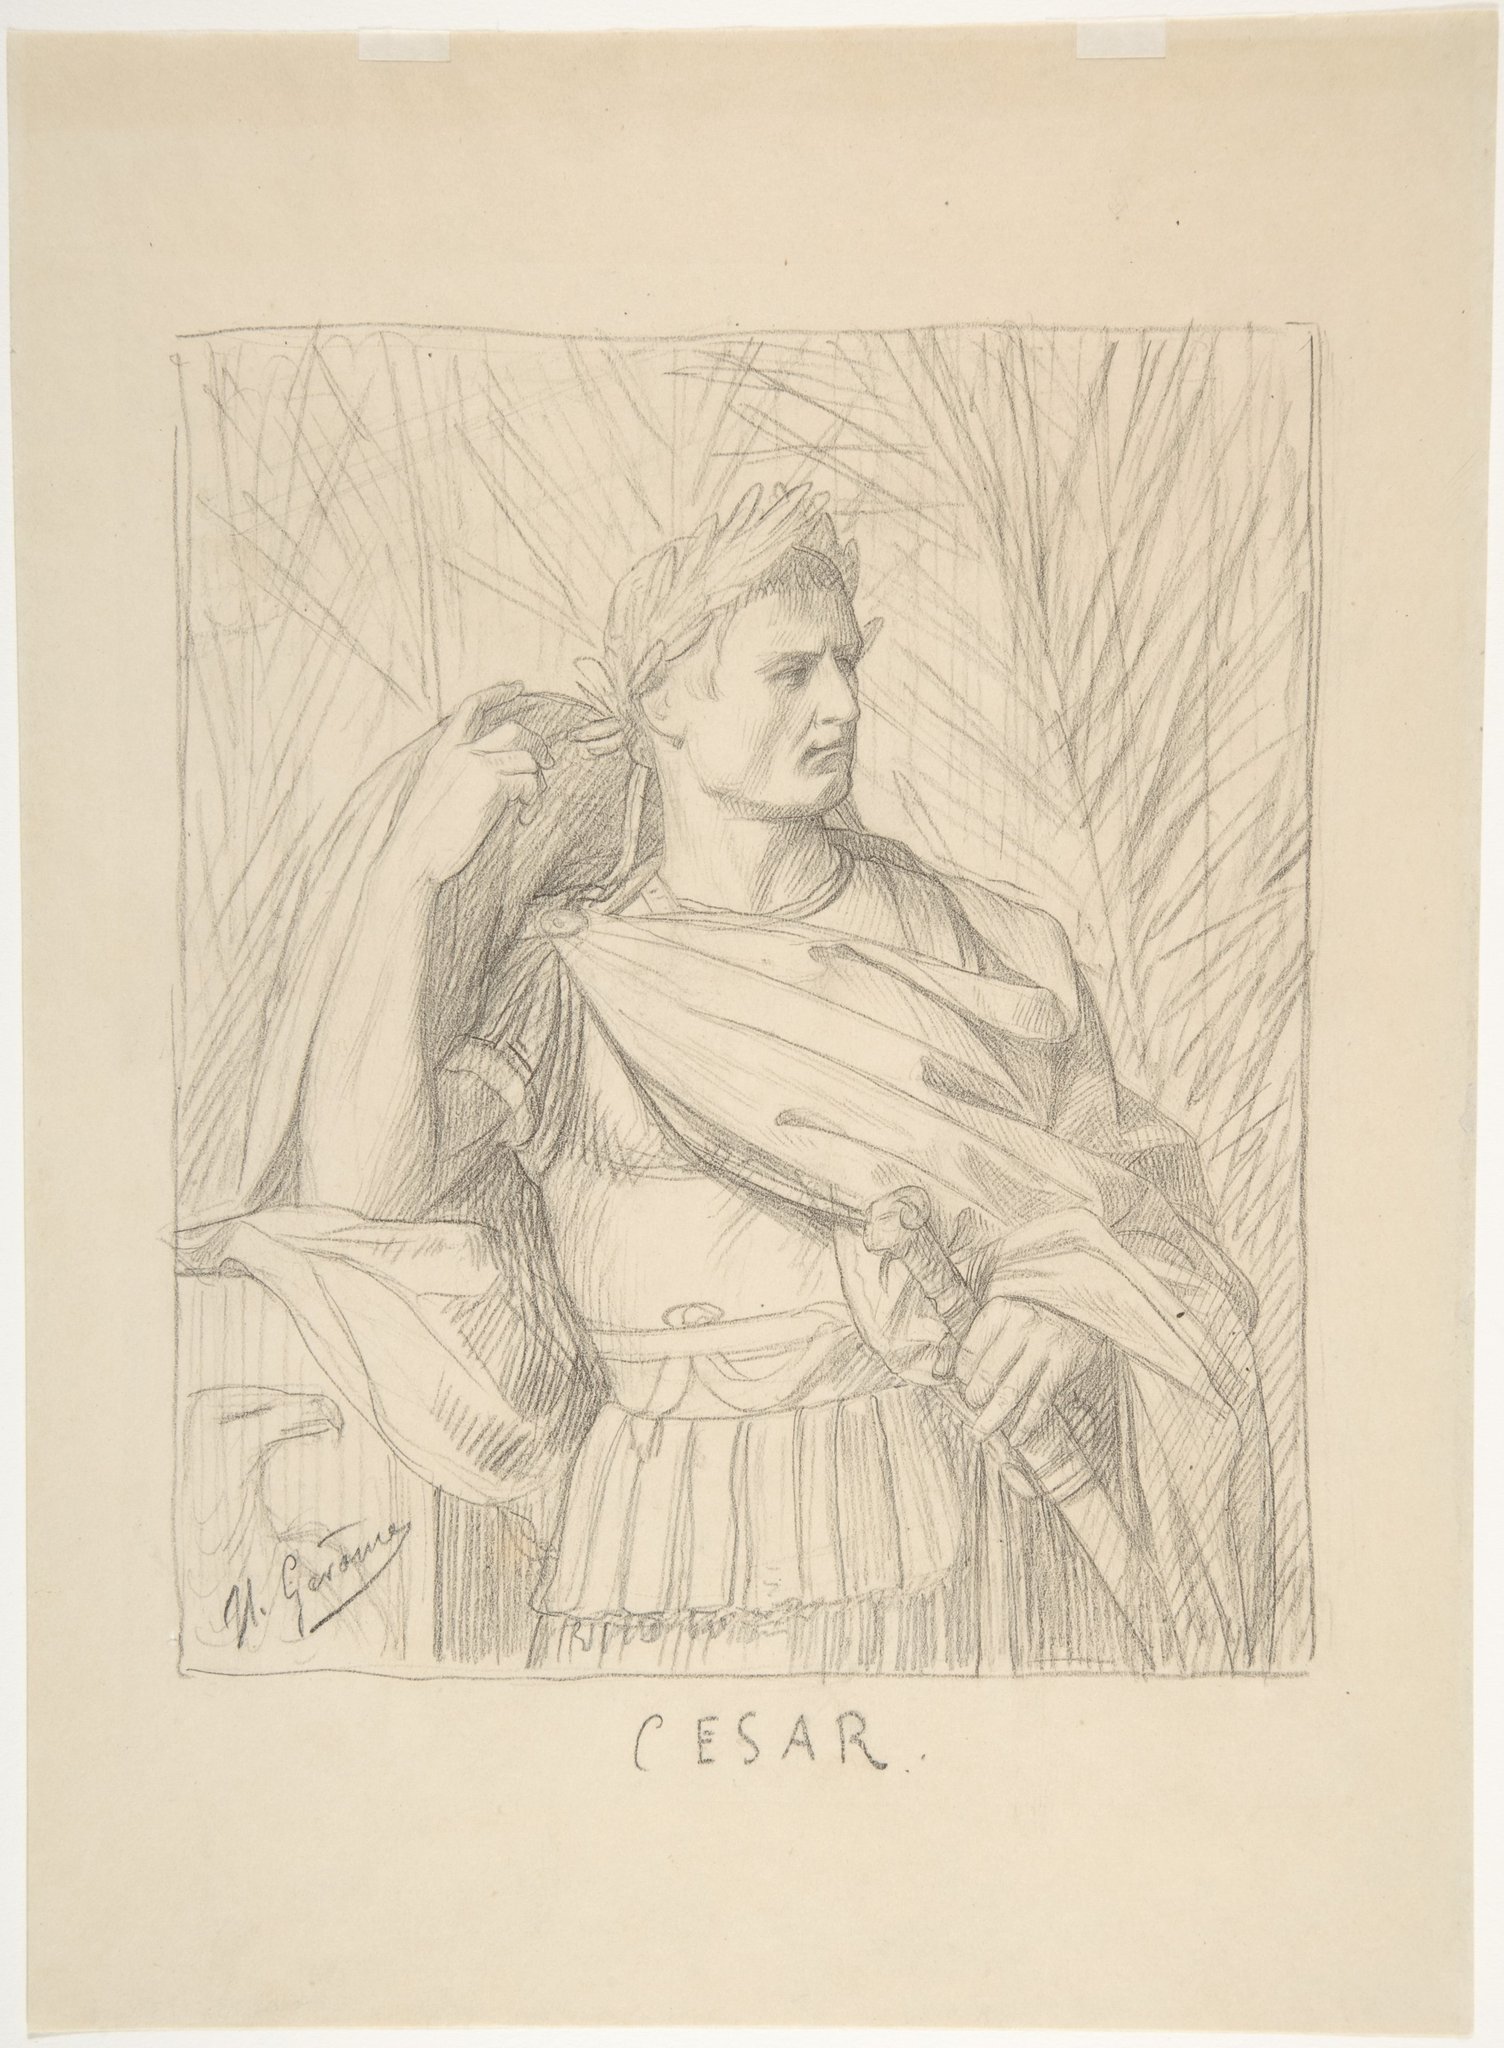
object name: drawing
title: Julius Caesar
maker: jean-léon gérôme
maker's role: artist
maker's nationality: french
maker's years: 1824-1904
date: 1863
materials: graphite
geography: france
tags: julius caesar